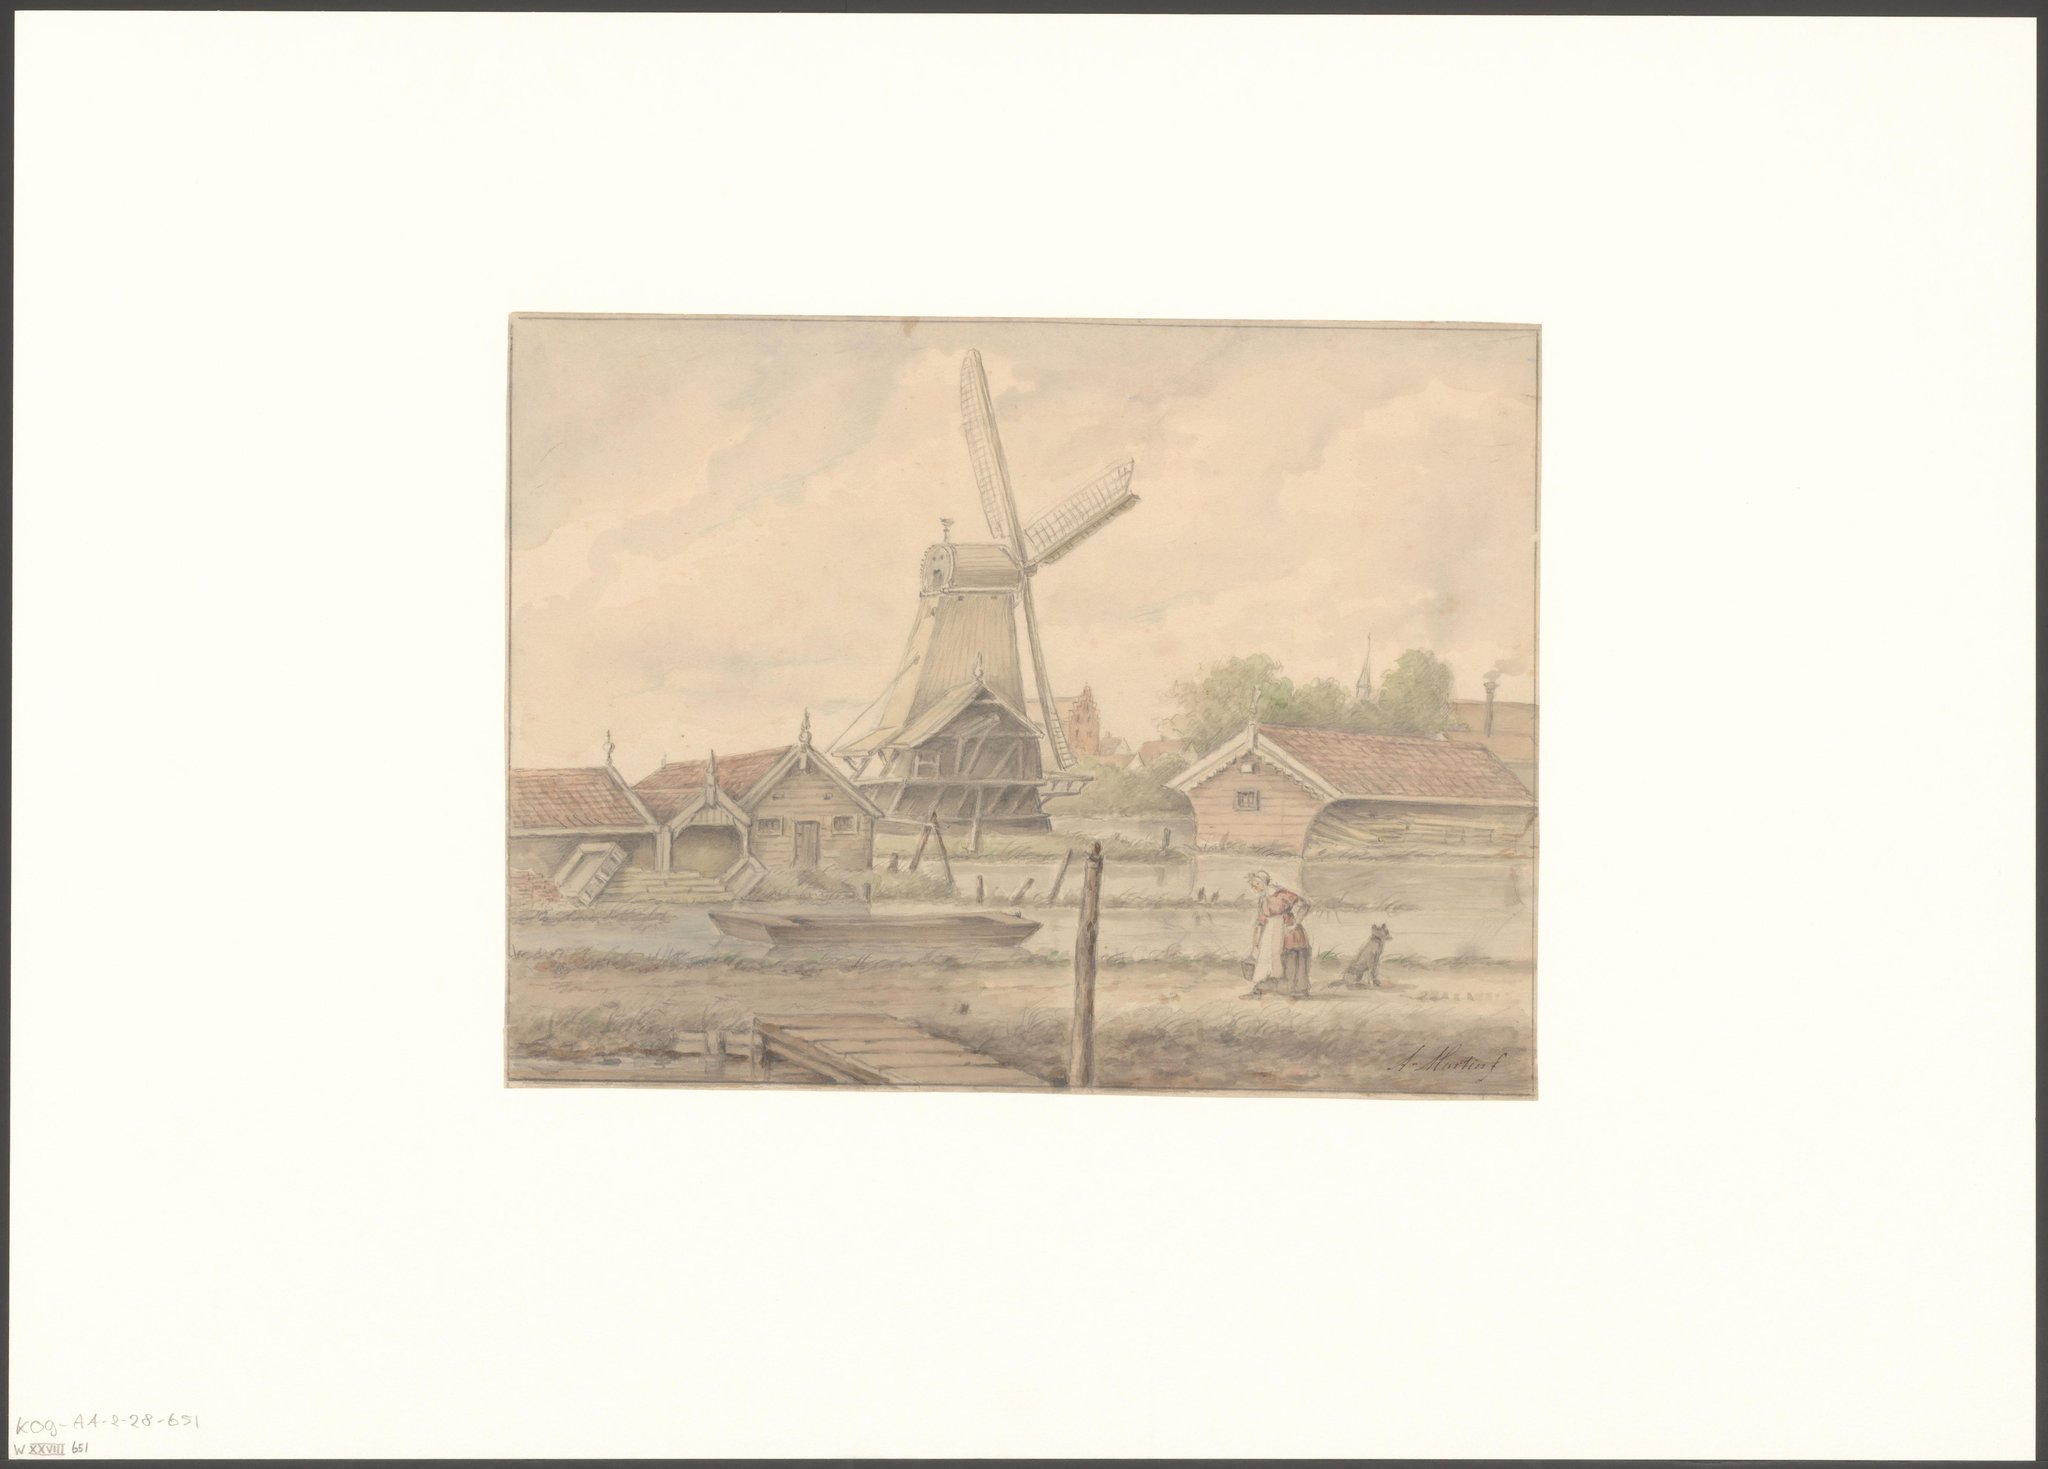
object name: drawing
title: Gezicht op molen De Kop vanaf de Middenweg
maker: albert martin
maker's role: draughtsman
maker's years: 1827-1900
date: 1837-1900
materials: paper, pencil, watercolor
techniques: brush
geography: amsterdam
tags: city-view in general; 'veduta', canal, windmill in landscape, boat propelled by man or animal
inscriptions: inscription: ‘Midden weg Molen de Kop’, collector's mark: Lugt 800a, signature: ‘A.Martin f’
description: Tekening binnen de Atlas Van Eck ingedeeld op wijknummer 28.